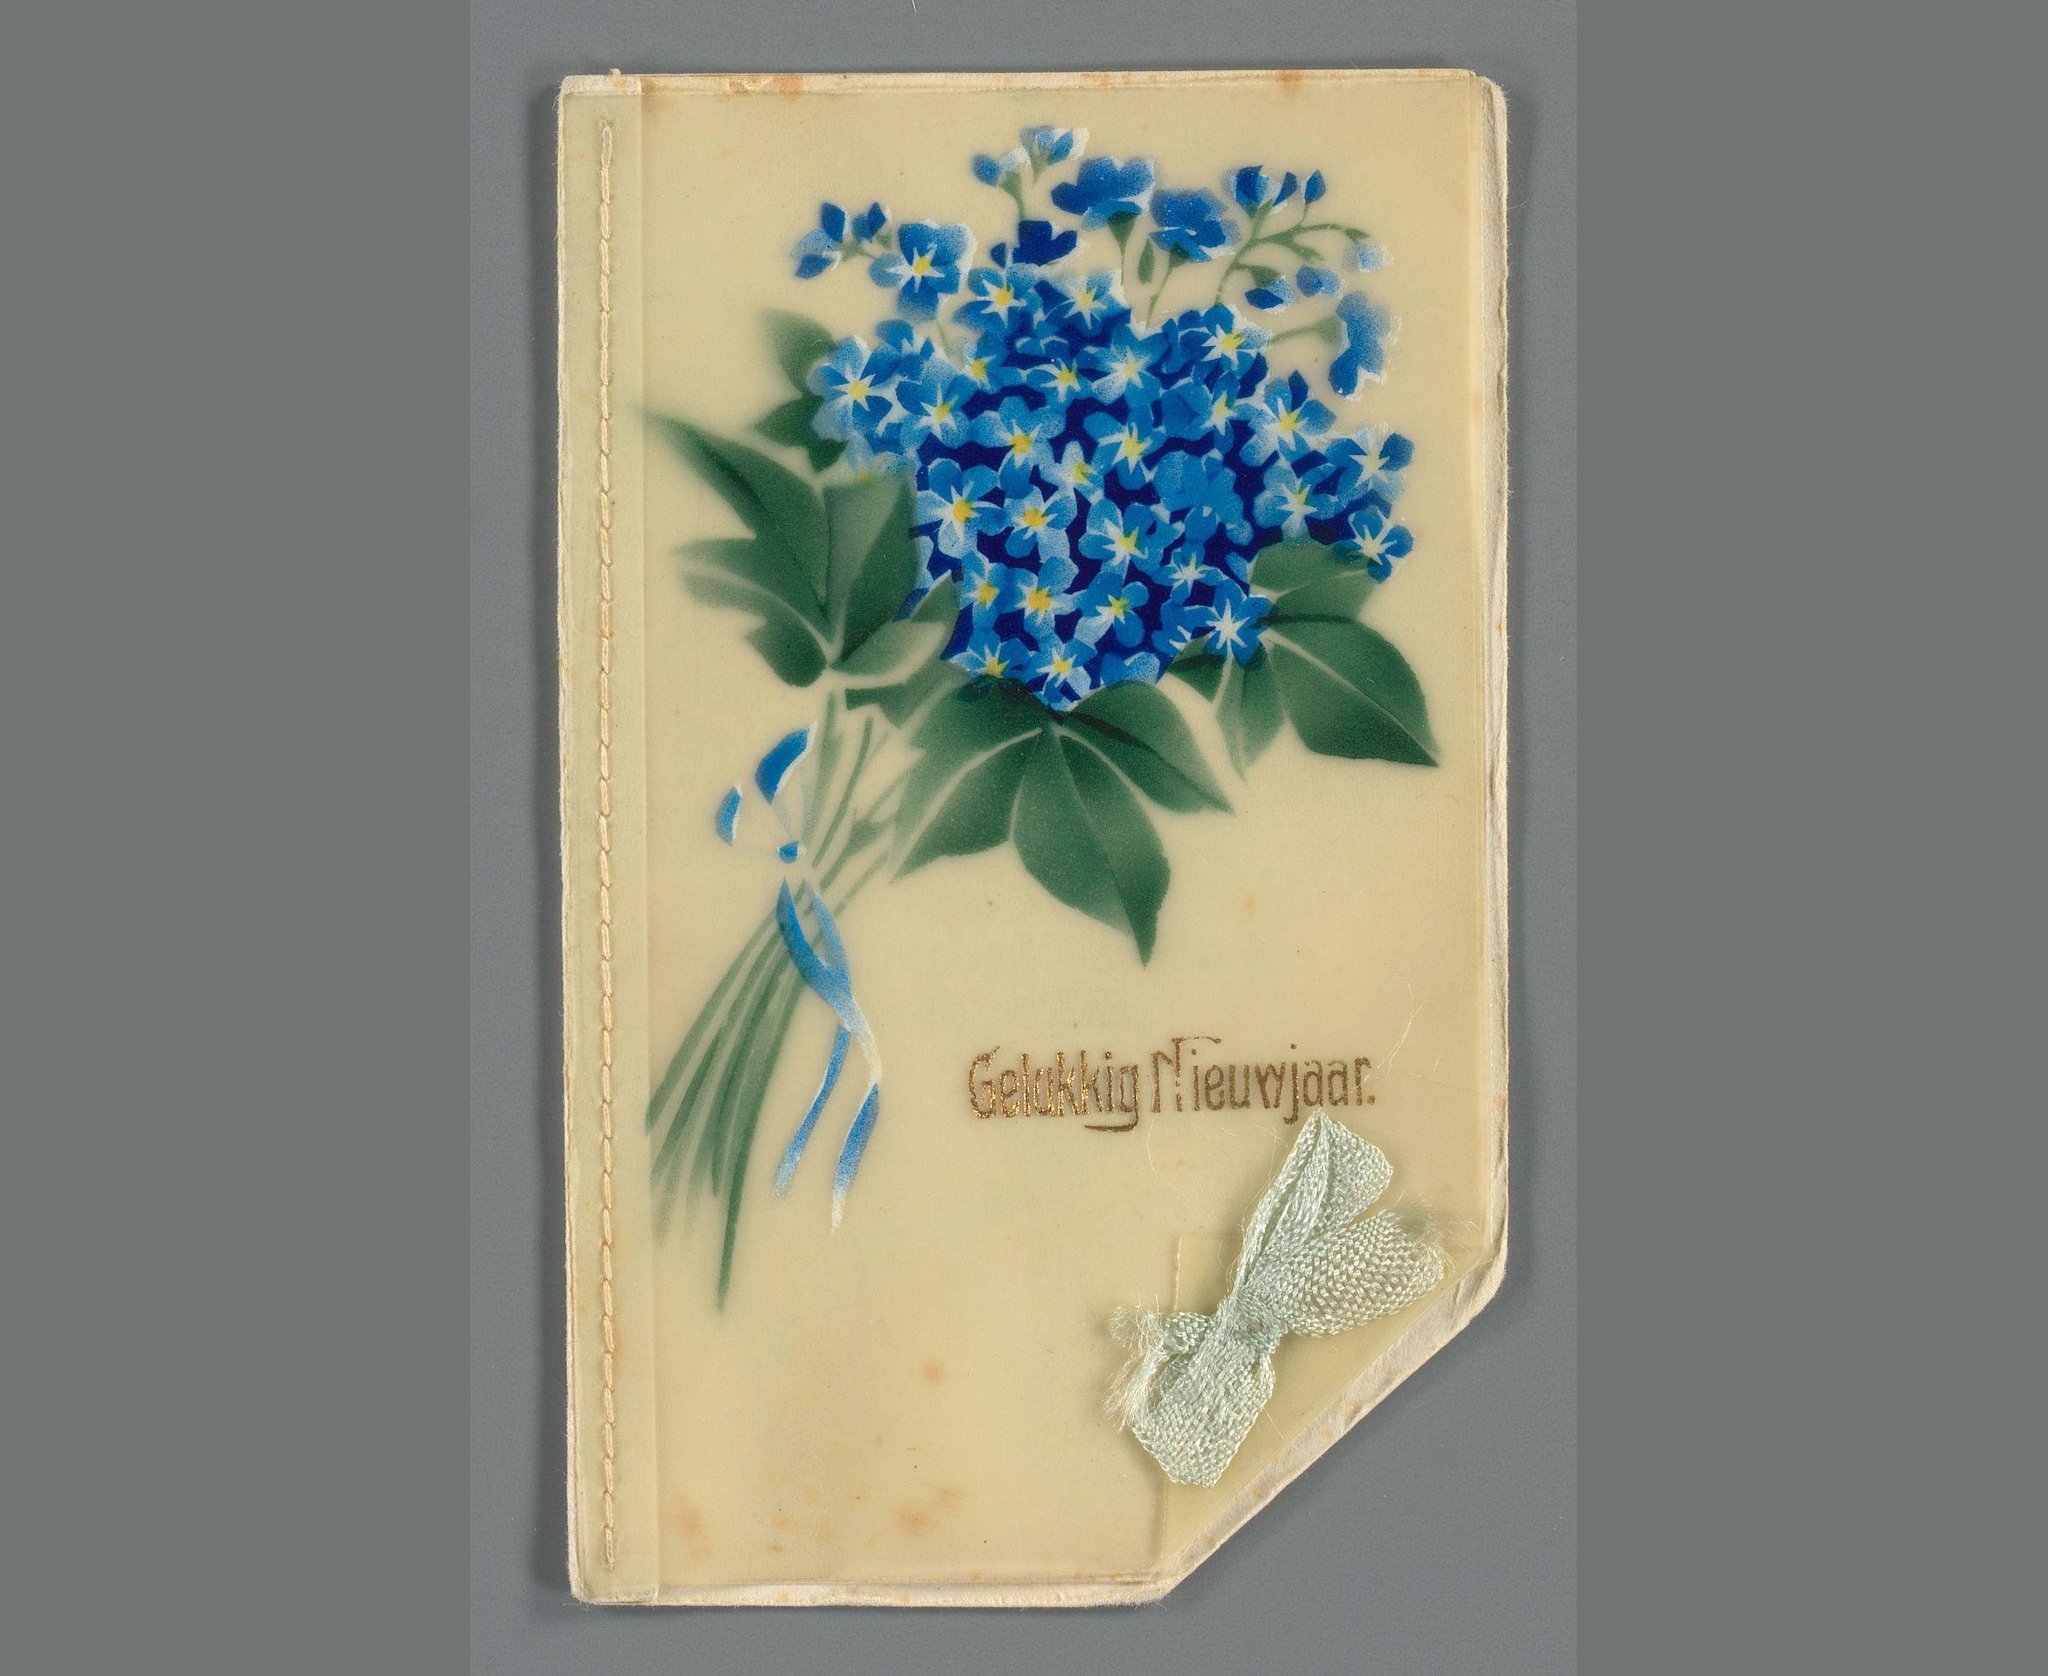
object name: print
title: Gelukkig Nieuwjaar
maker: Anonymous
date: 1940-1960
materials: paper, pencil, textile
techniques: lithograph, letterpress printing, stitching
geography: netherlands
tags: cut flowers; nosegay, bunch of flowers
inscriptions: inscription: ‘Het oude jaar (...) Je Moeder.’